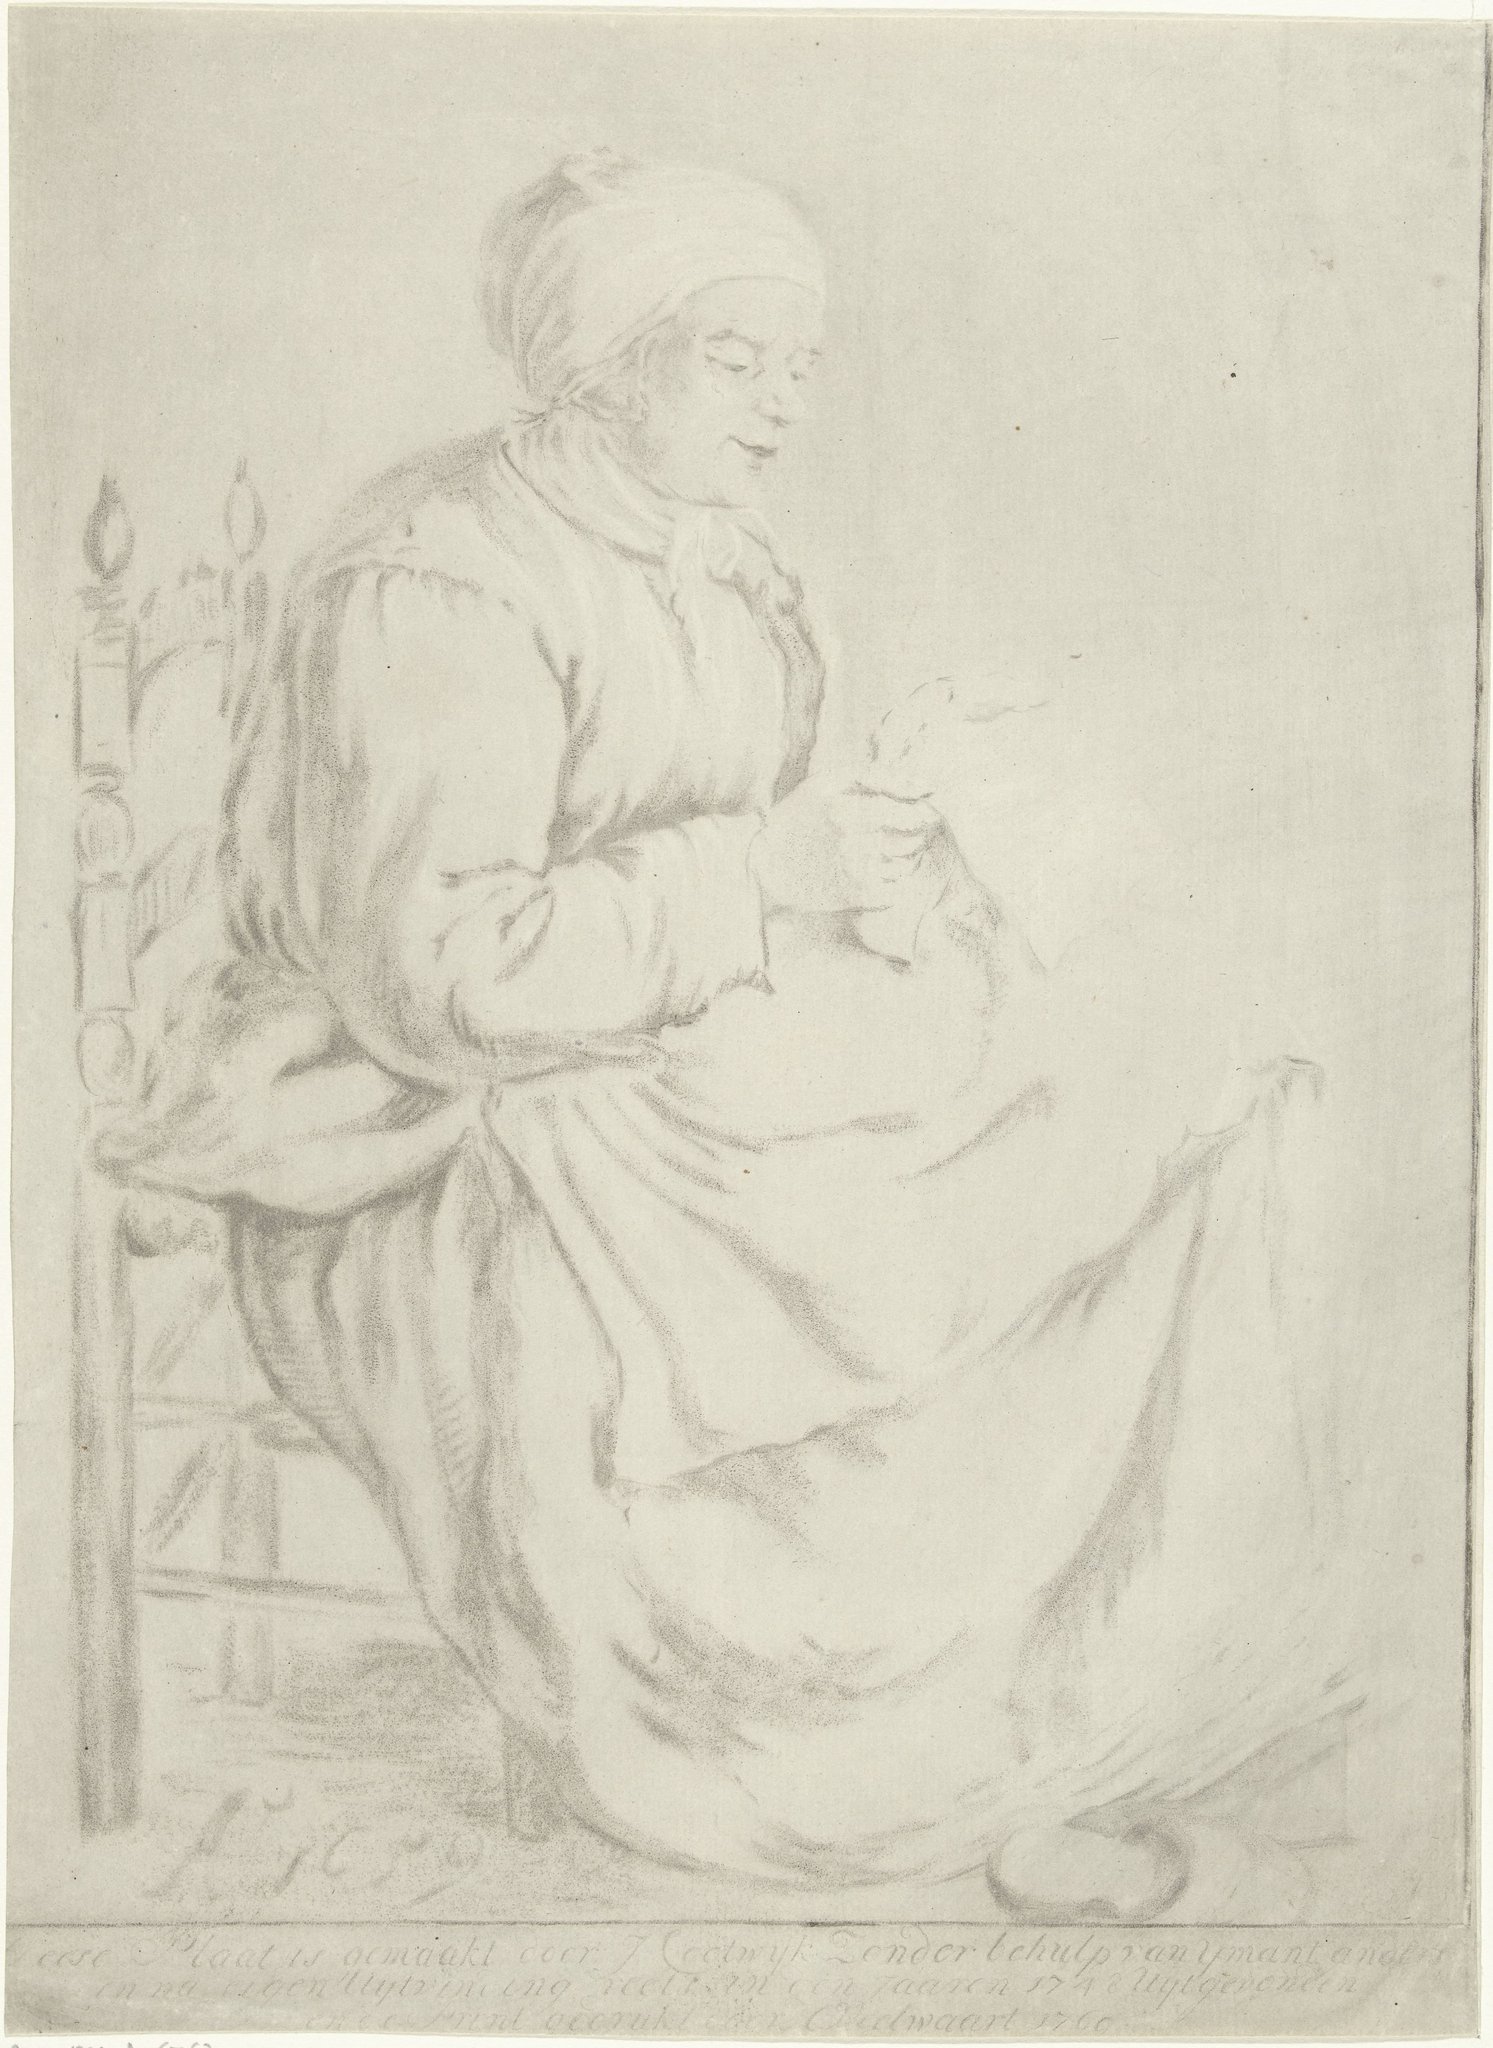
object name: print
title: Lezende oude vrouw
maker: jurriaan cootwijck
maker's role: print maker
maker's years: 1714-1798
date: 1760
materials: paper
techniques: print drawing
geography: amsterdam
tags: reading, old woman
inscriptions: collector's mark: Lugt 2228, caption: ‘Deese Plaat is gemaakt door J. Cortwijk zonder behulp van IJmant anders en na eigen uitvinding reets in deb jaaren 1748 uitgevonden en de print gedrukt door Veelwaart 1760’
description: Een oude vrouw zit op een stoel en leest een blad papier. De prent heeft een Nederlands onderschrift.